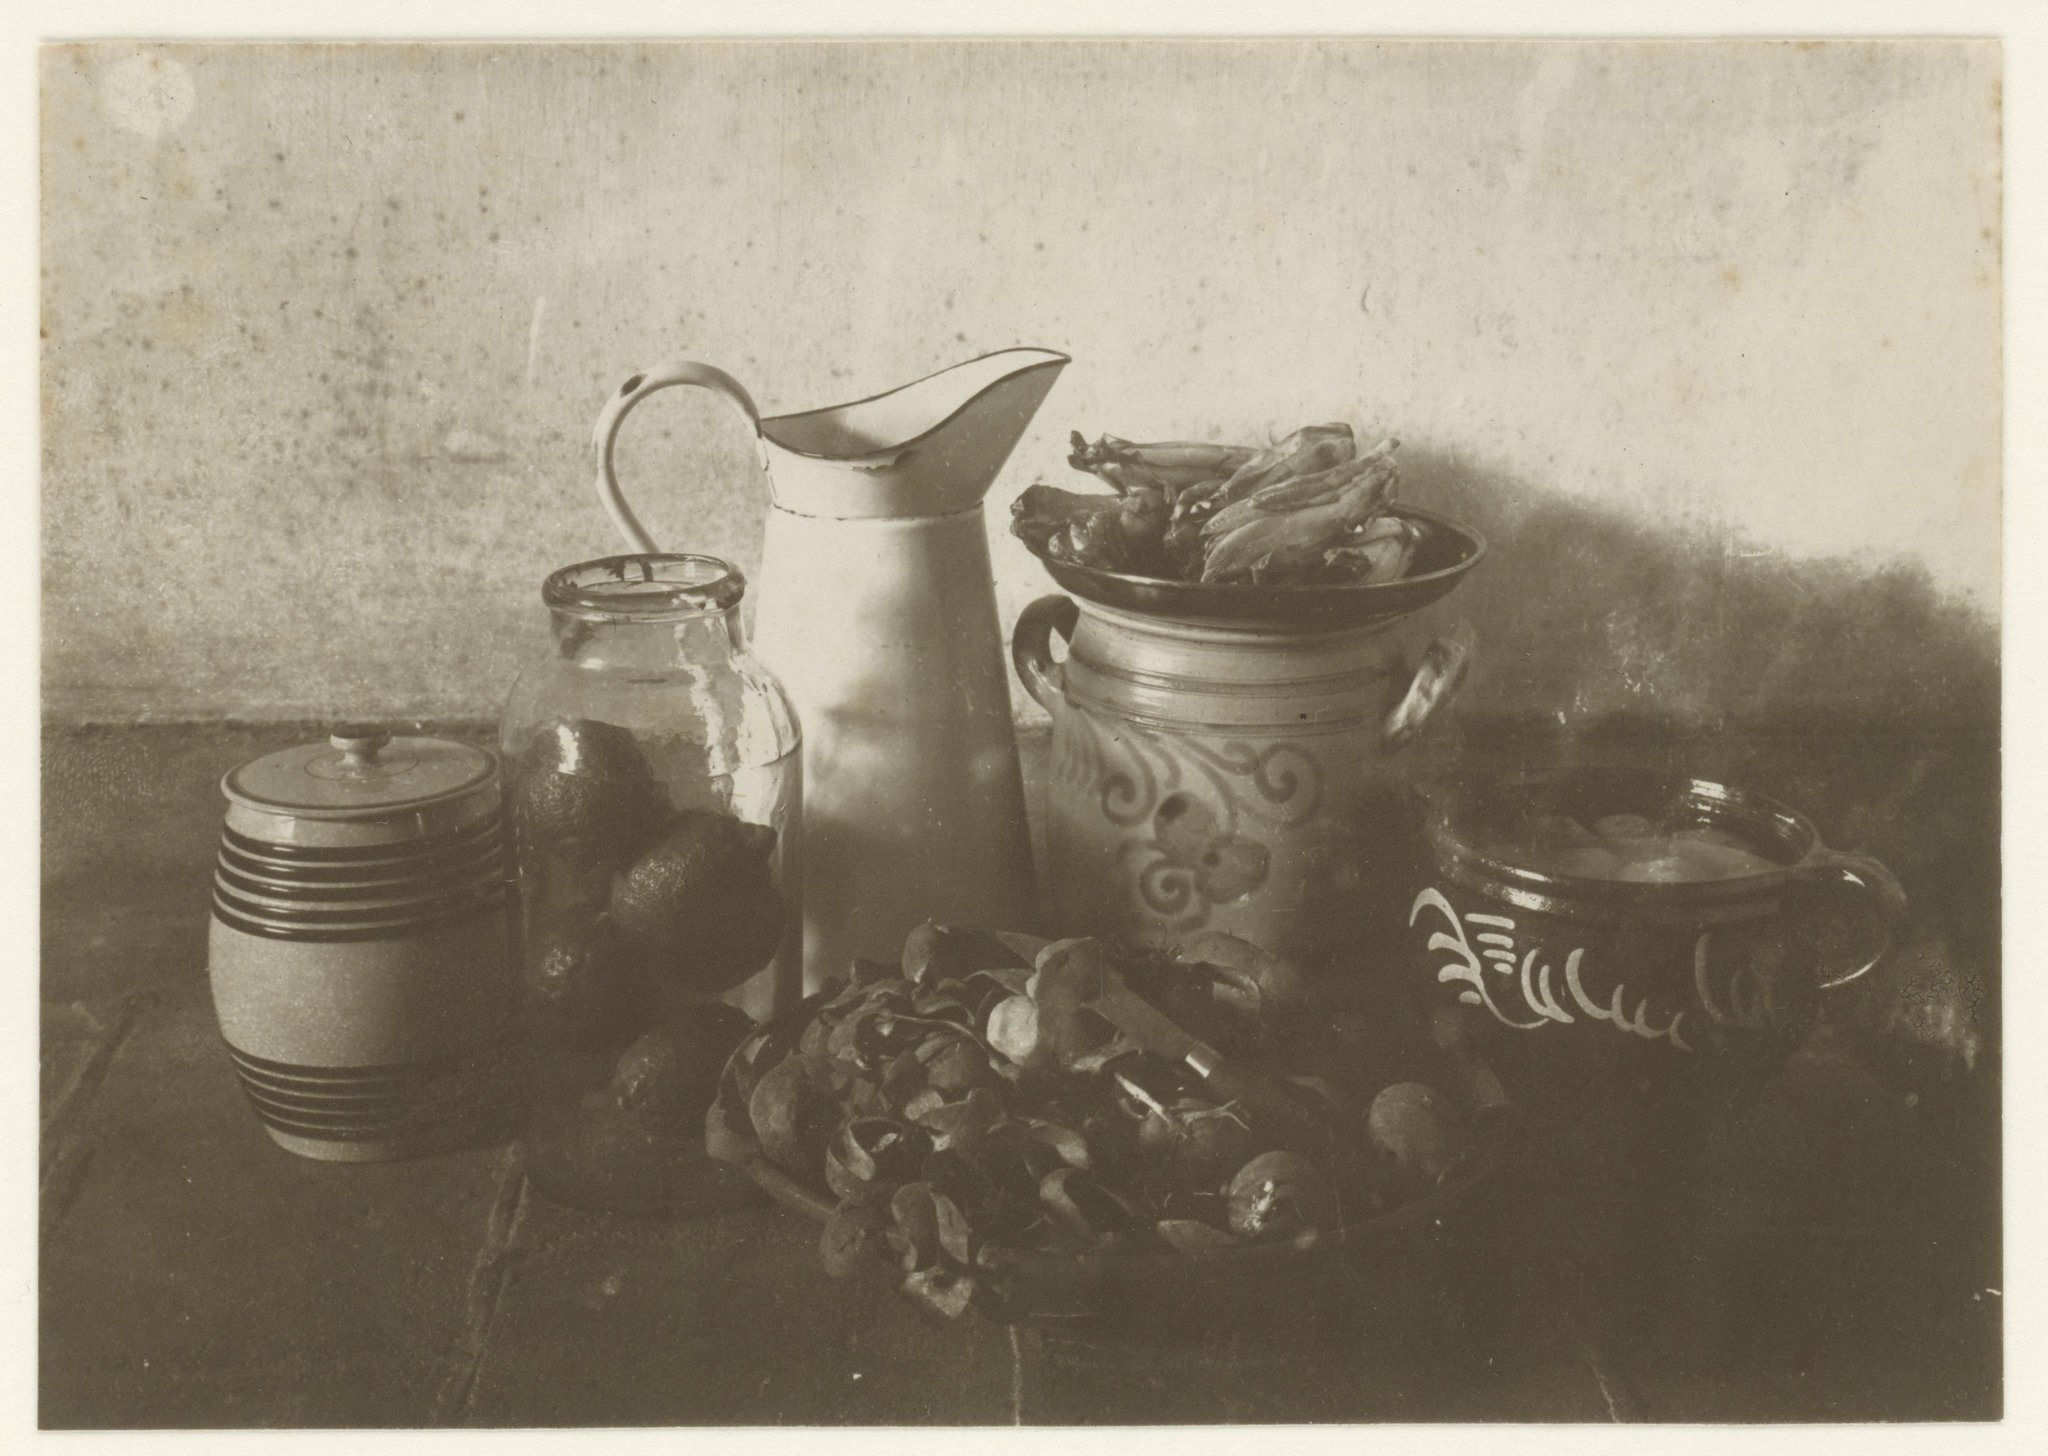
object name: photograph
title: Stilleven met kan en potten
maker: richard tepe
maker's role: fotograaf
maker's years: 1864-1952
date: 1900-1930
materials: photographic support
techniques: carbon print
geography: netherlands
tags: still life of related objects